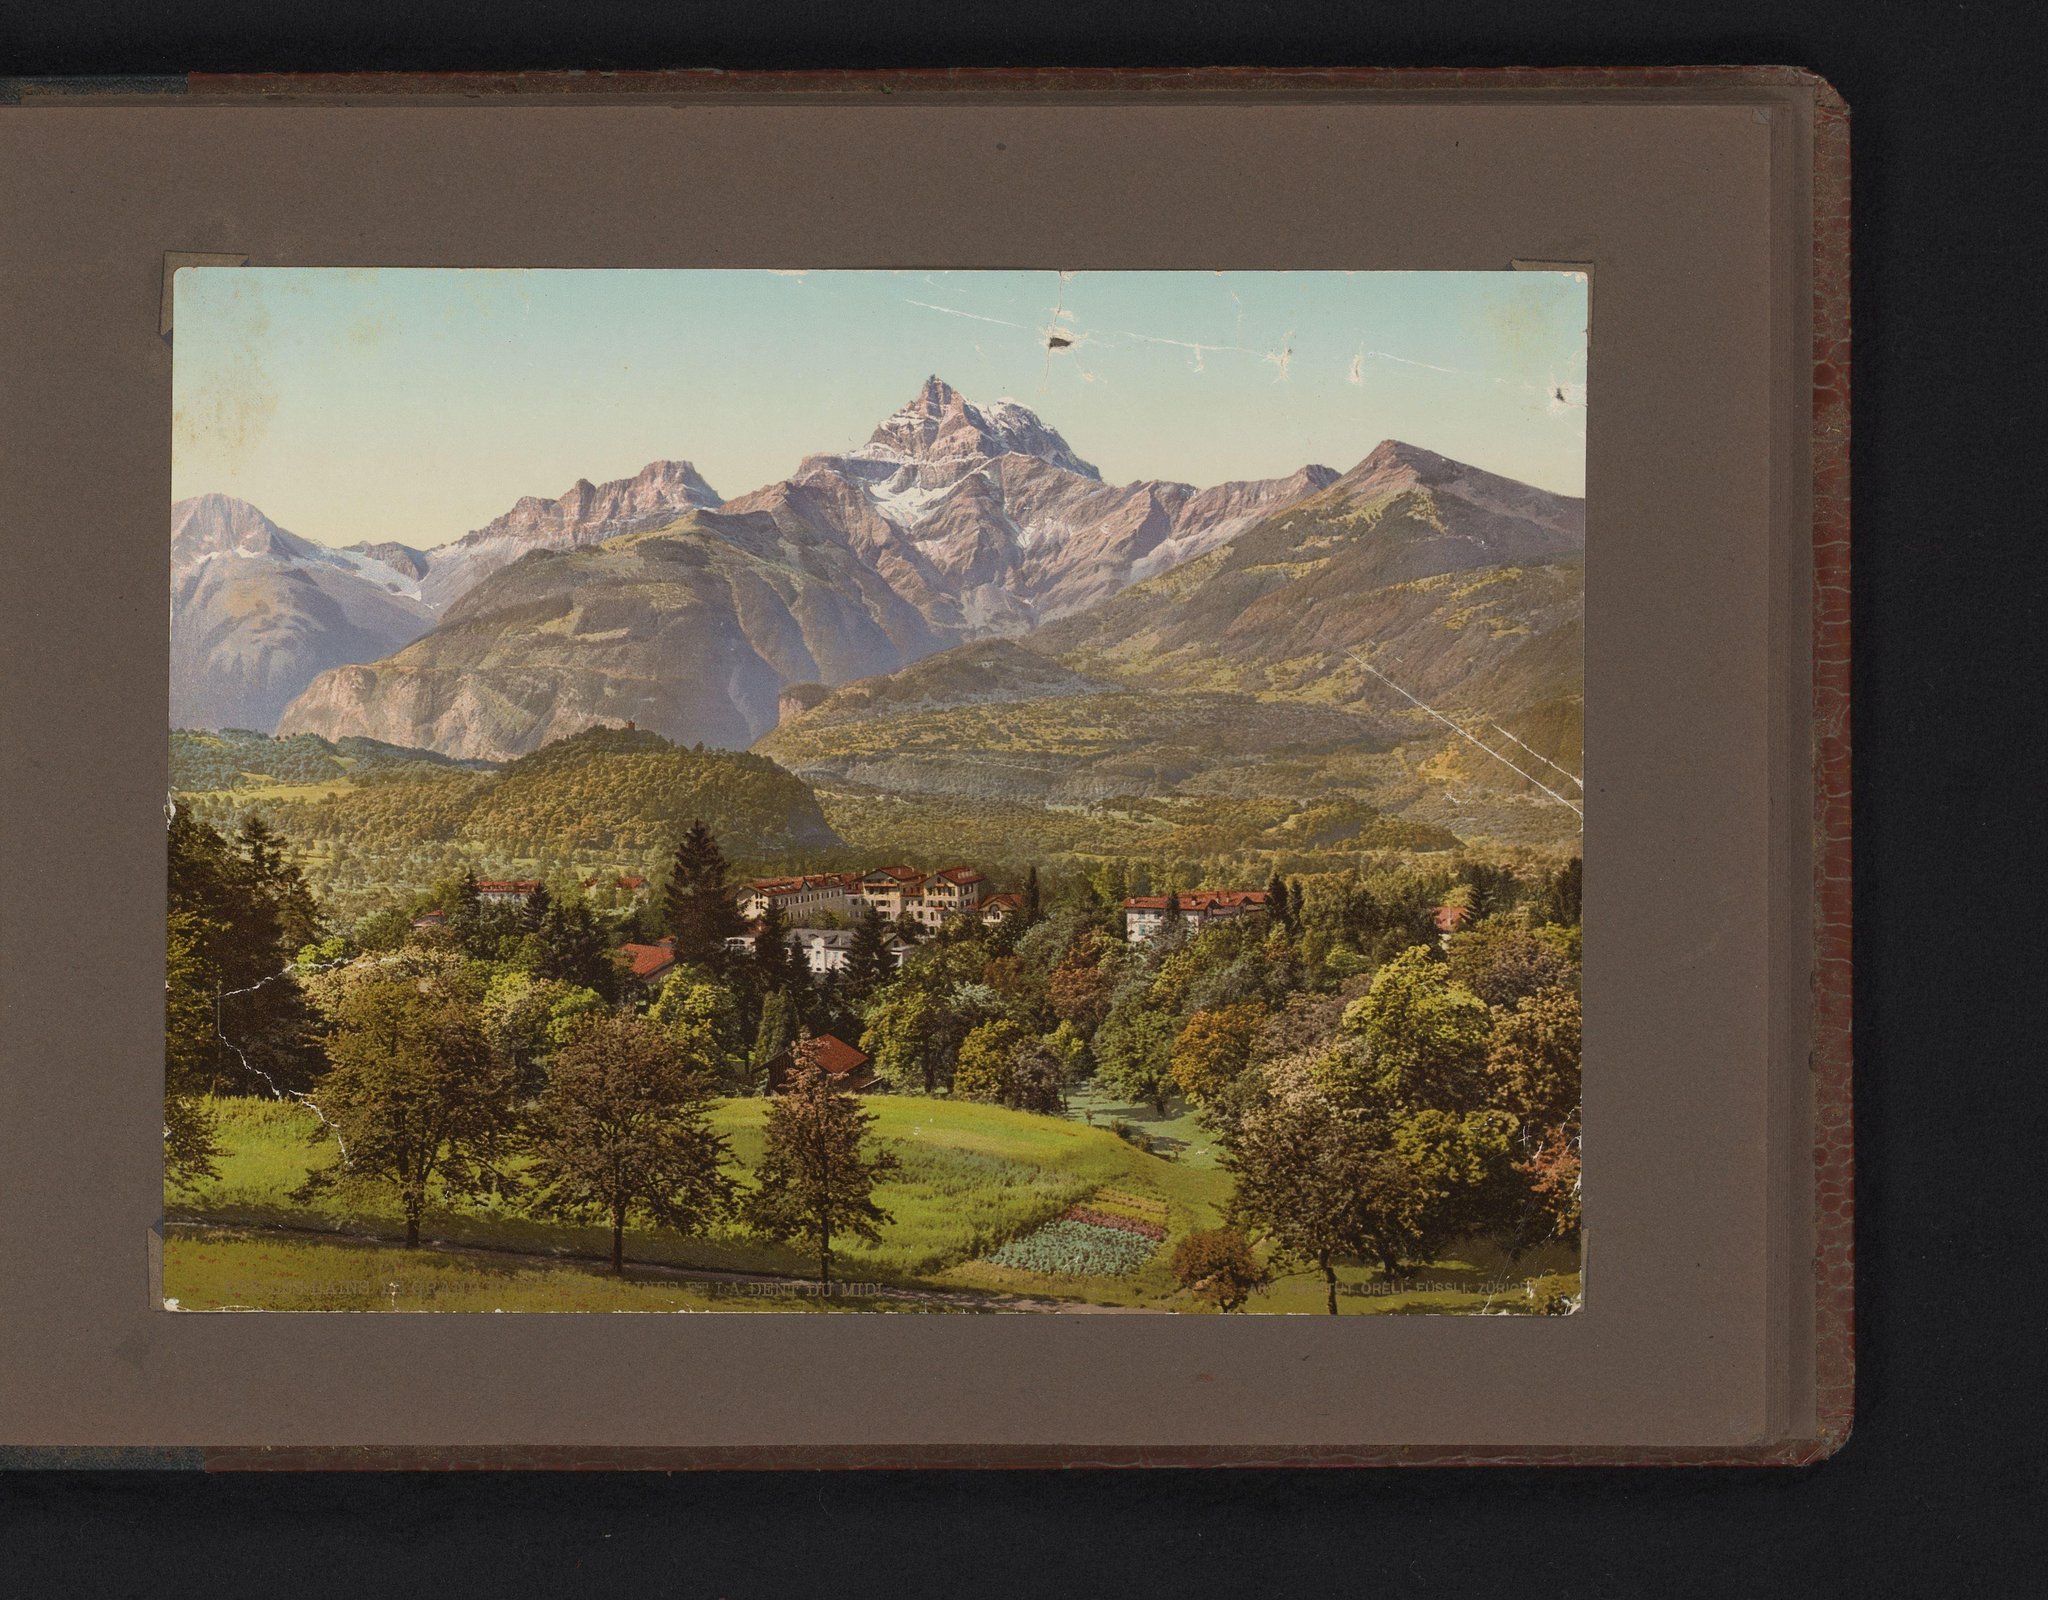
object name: photomechanical print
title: Gezicht op Grand Hôtel des Salines te Rheinfelden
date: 1930-1940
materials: paper, photographic process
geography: zurich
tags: hotel, hostelry, inn, mountains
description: Deze pagina maakt deel uit van een album.